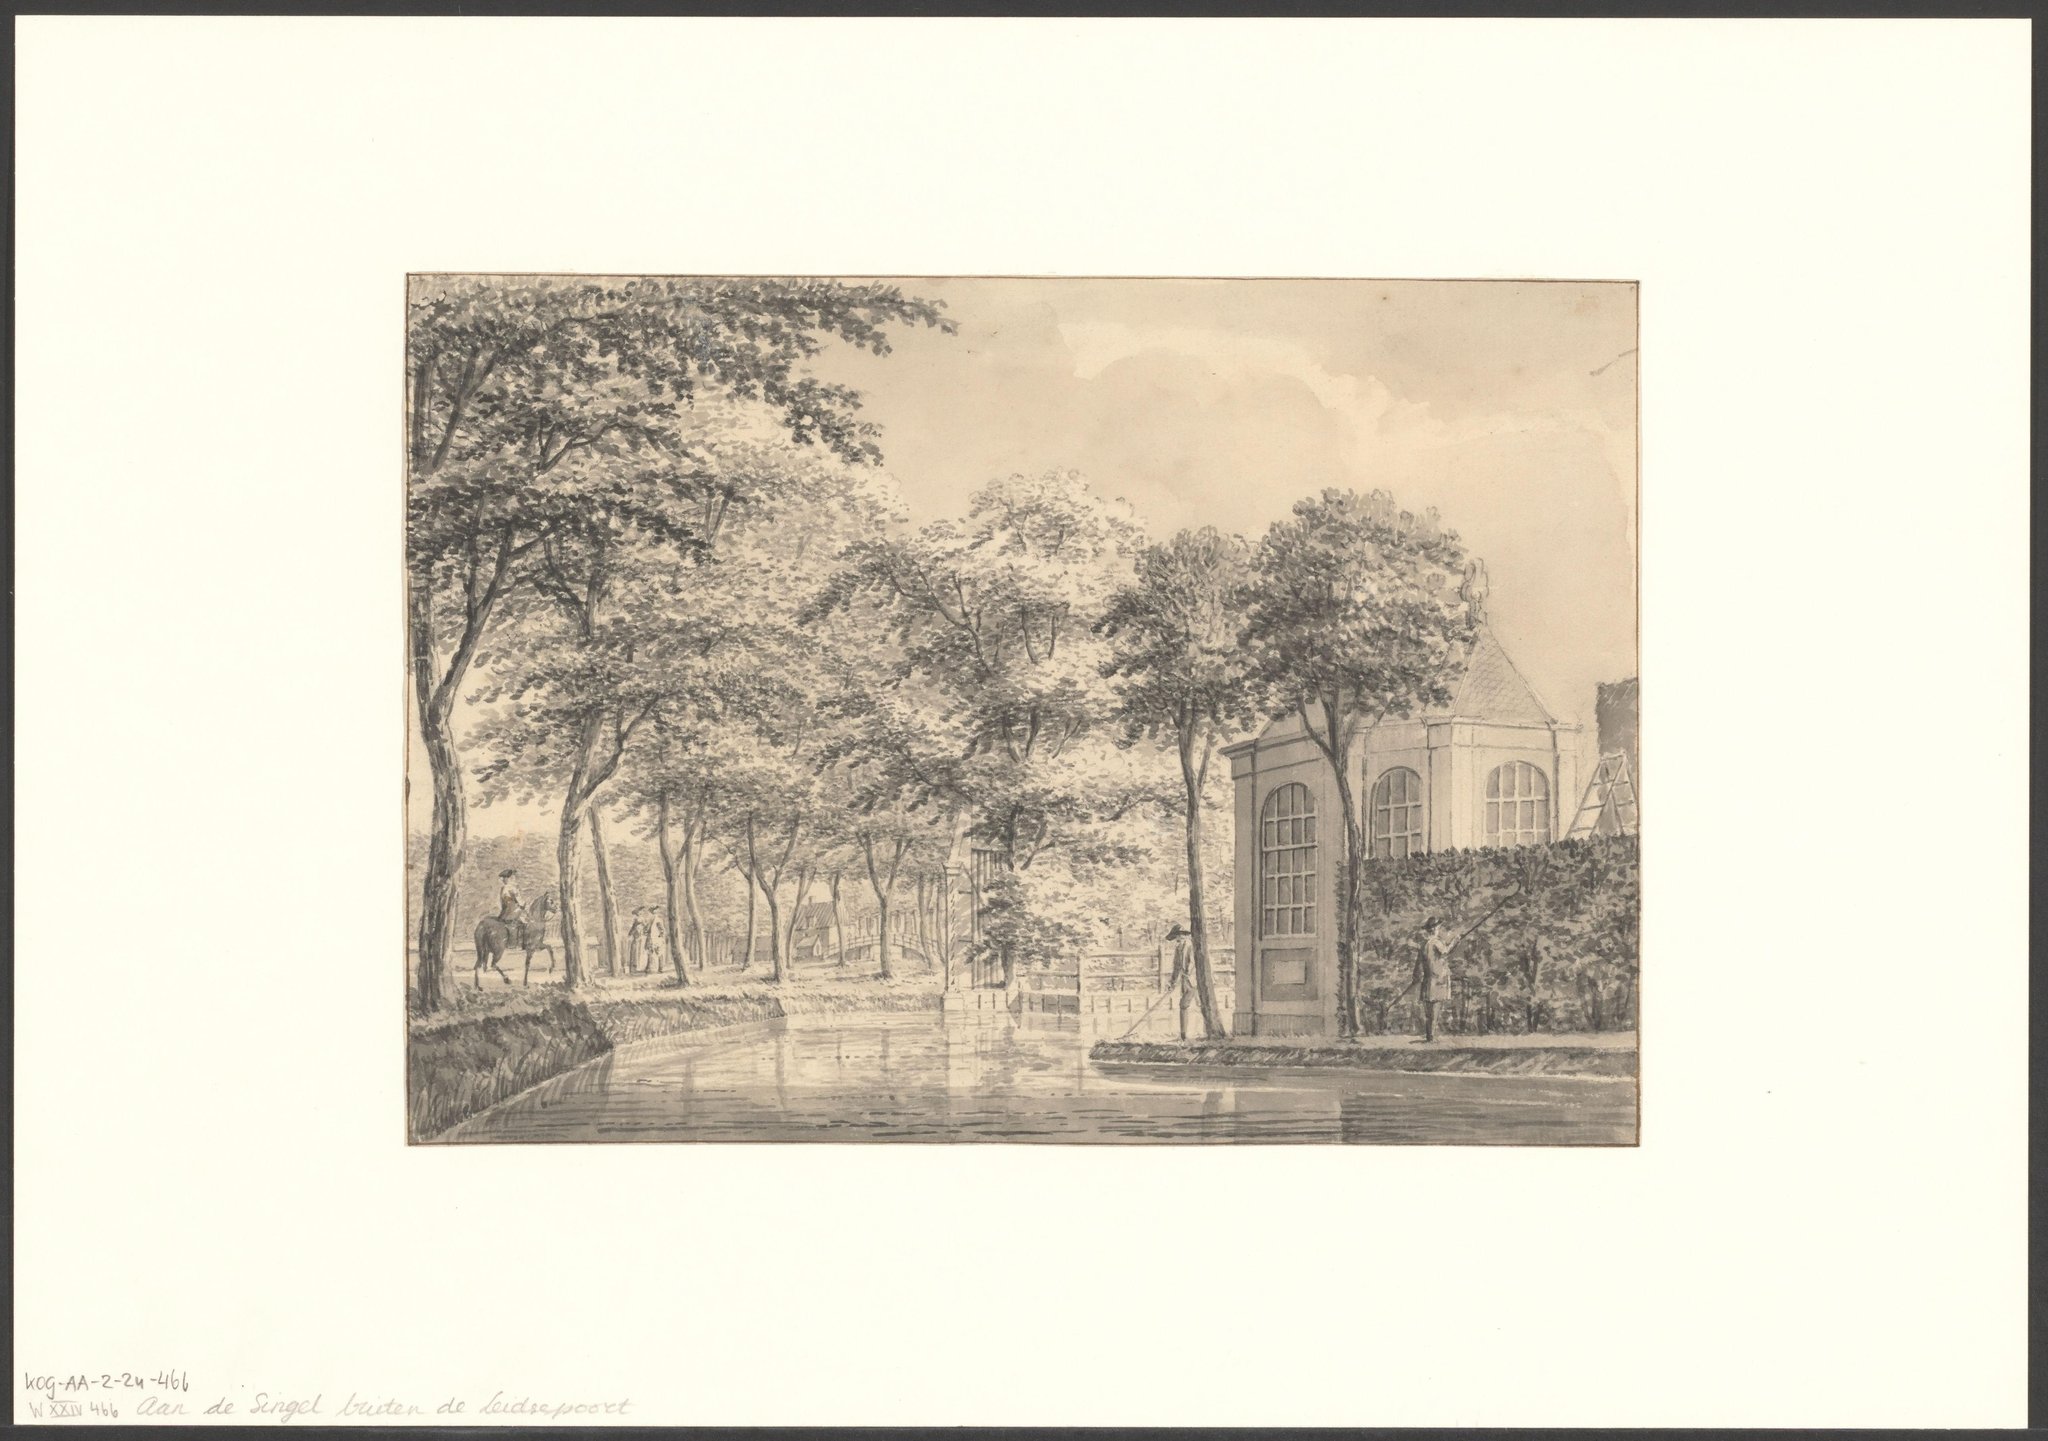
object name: drawing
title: Gezicht op de Buitensingel bij de Leidsepoort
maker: jacobus kops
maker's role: draughtsman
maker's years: 1736-1773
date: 1756-1773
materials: chalk, ink, paper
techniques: brush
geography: amsterdam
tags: city-view in general; 'veduta', canal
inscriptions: collector's mark: Lugt 800a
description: Tekening binnen de Atlas Van Eck ingedeeld op wijknummer 24.